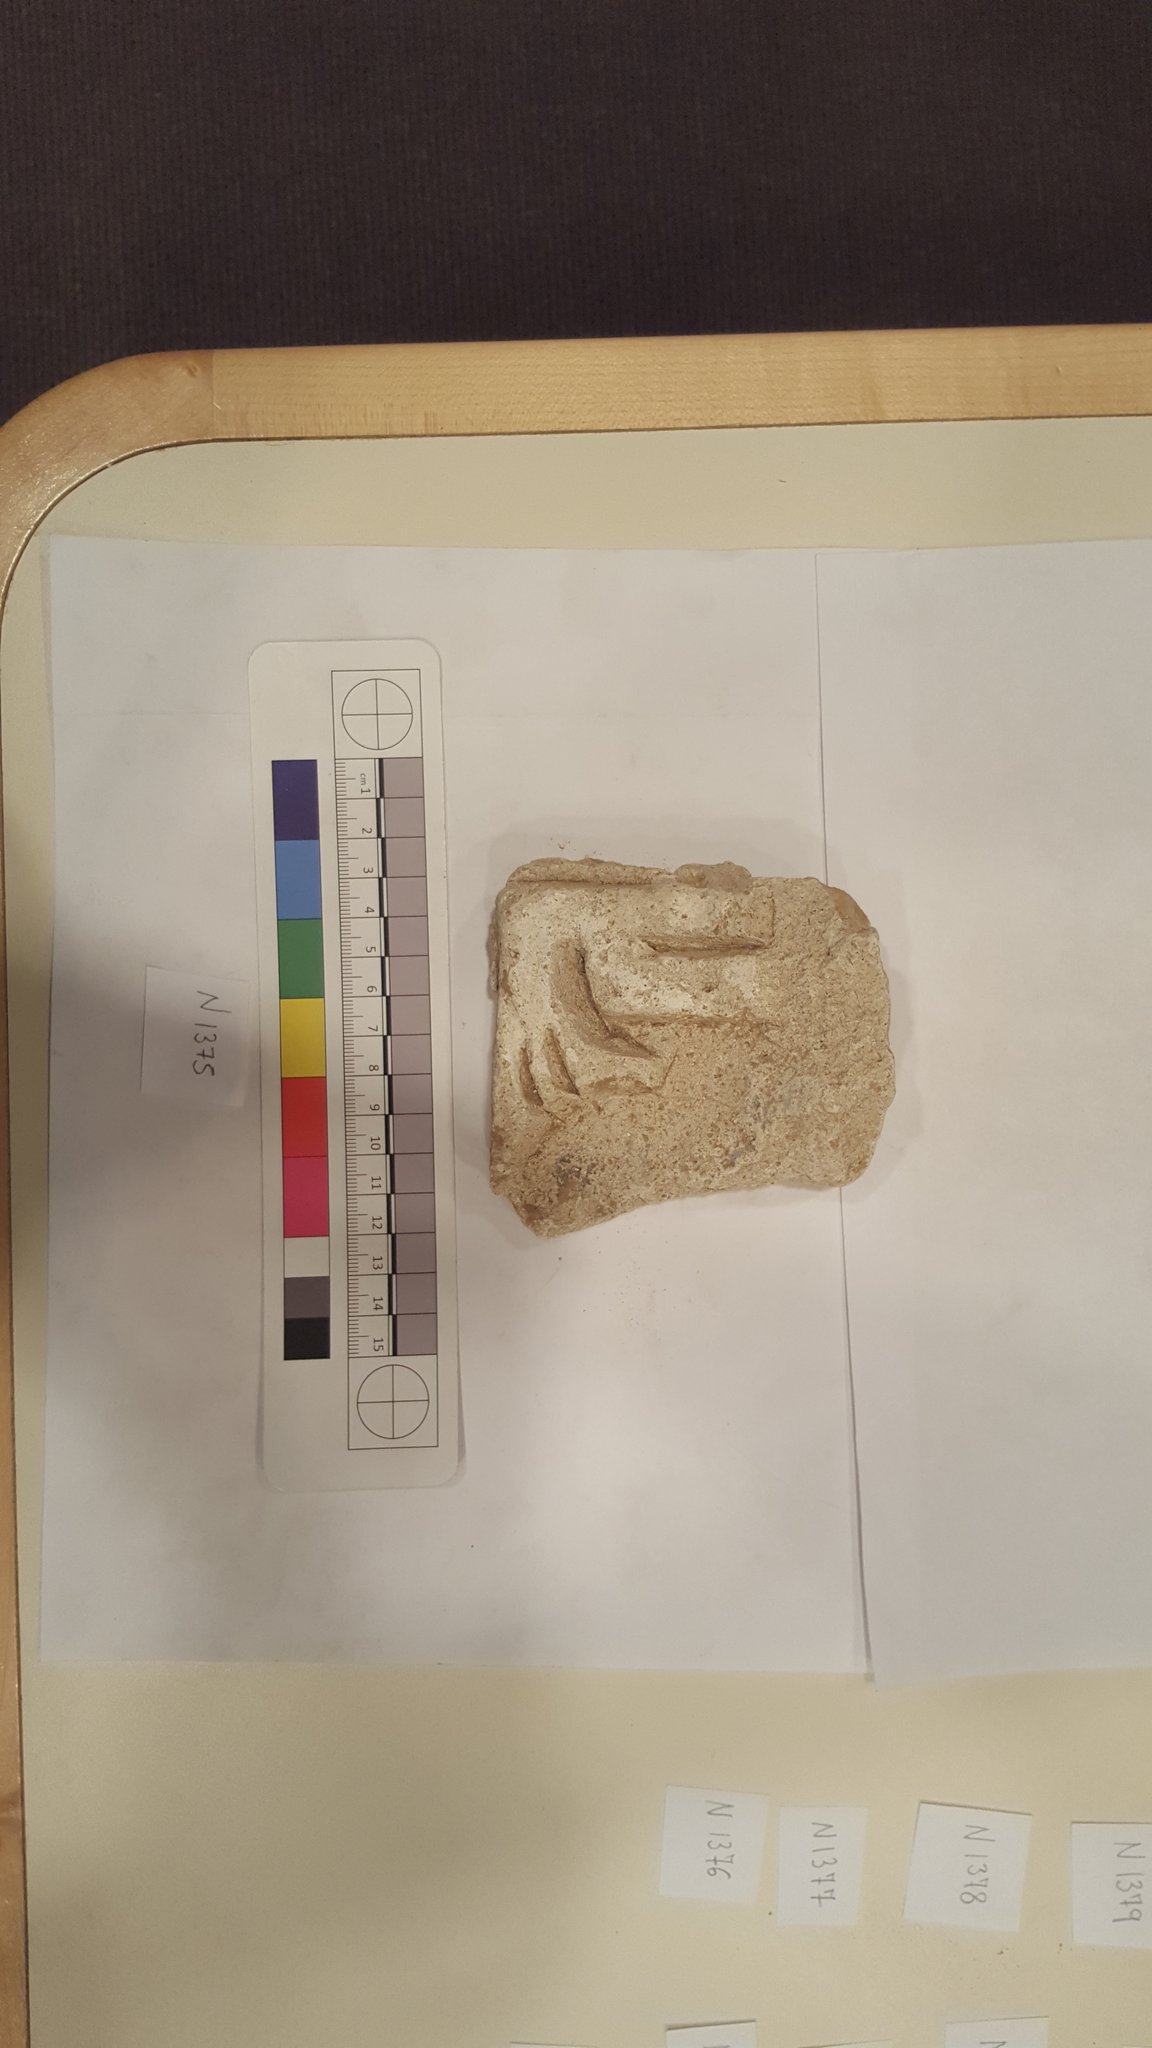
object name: fragment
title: Stucco Fragment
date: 701-1200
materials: plaster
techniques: carving, painting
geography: iran